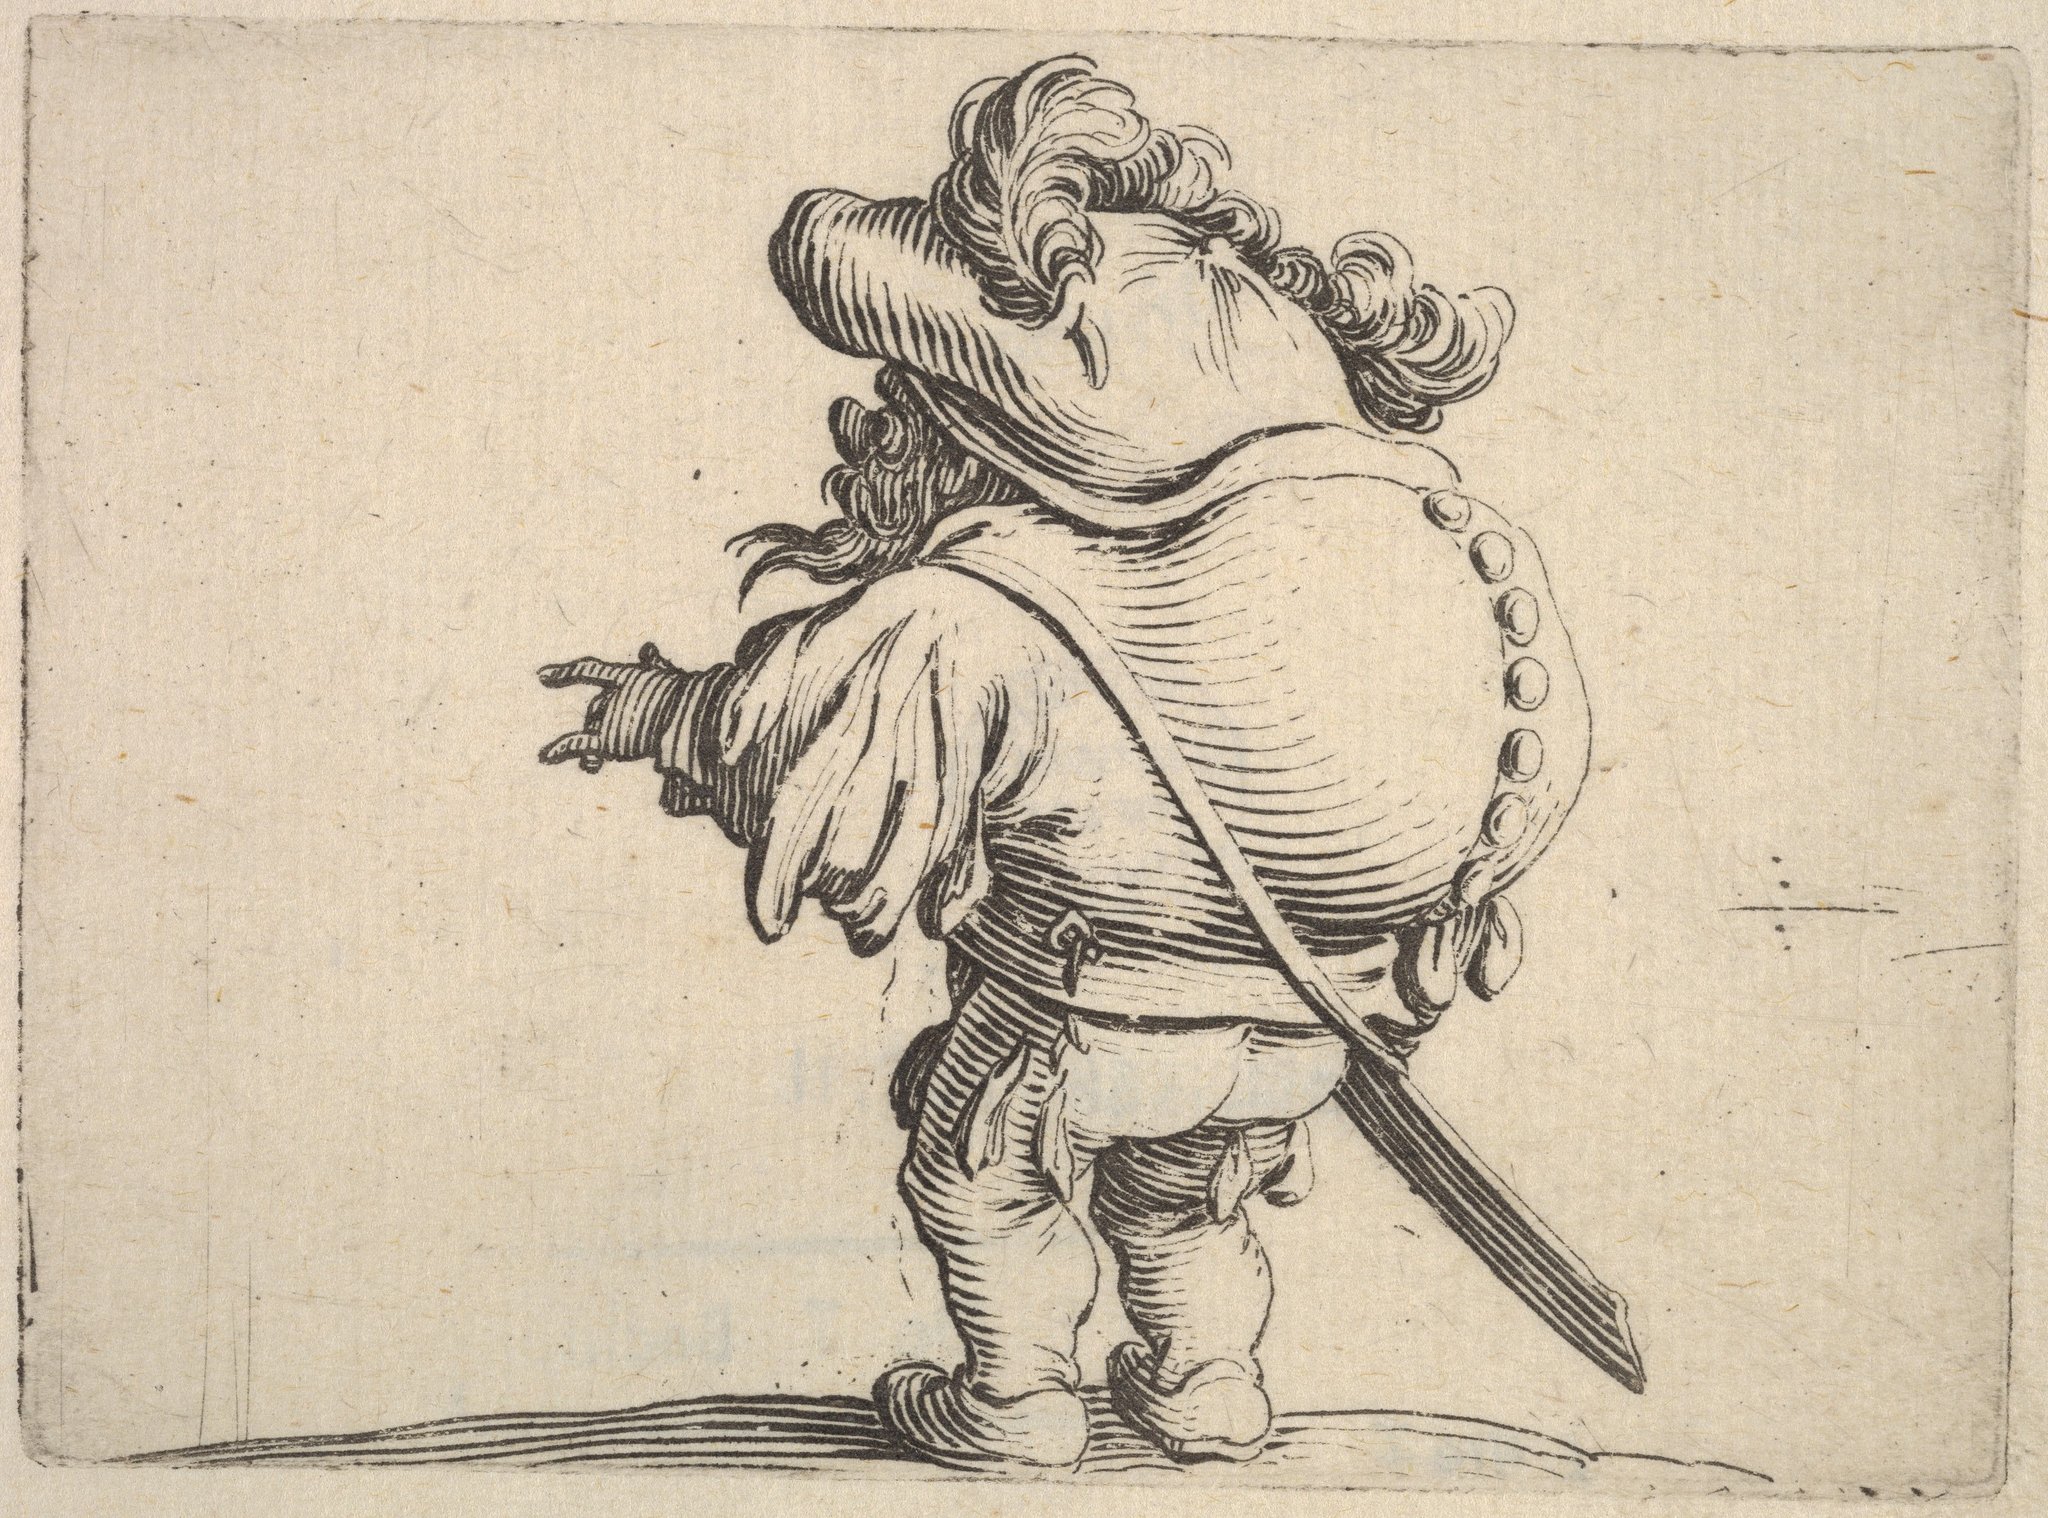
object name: print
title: Small male figure with outstreched left hand, seen from the back, which bulges, from "Varie Figure Gobbi"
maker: jacques callot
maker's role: artist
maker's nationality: french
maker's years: 1592-1635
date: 1621-1625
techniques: etching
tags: men